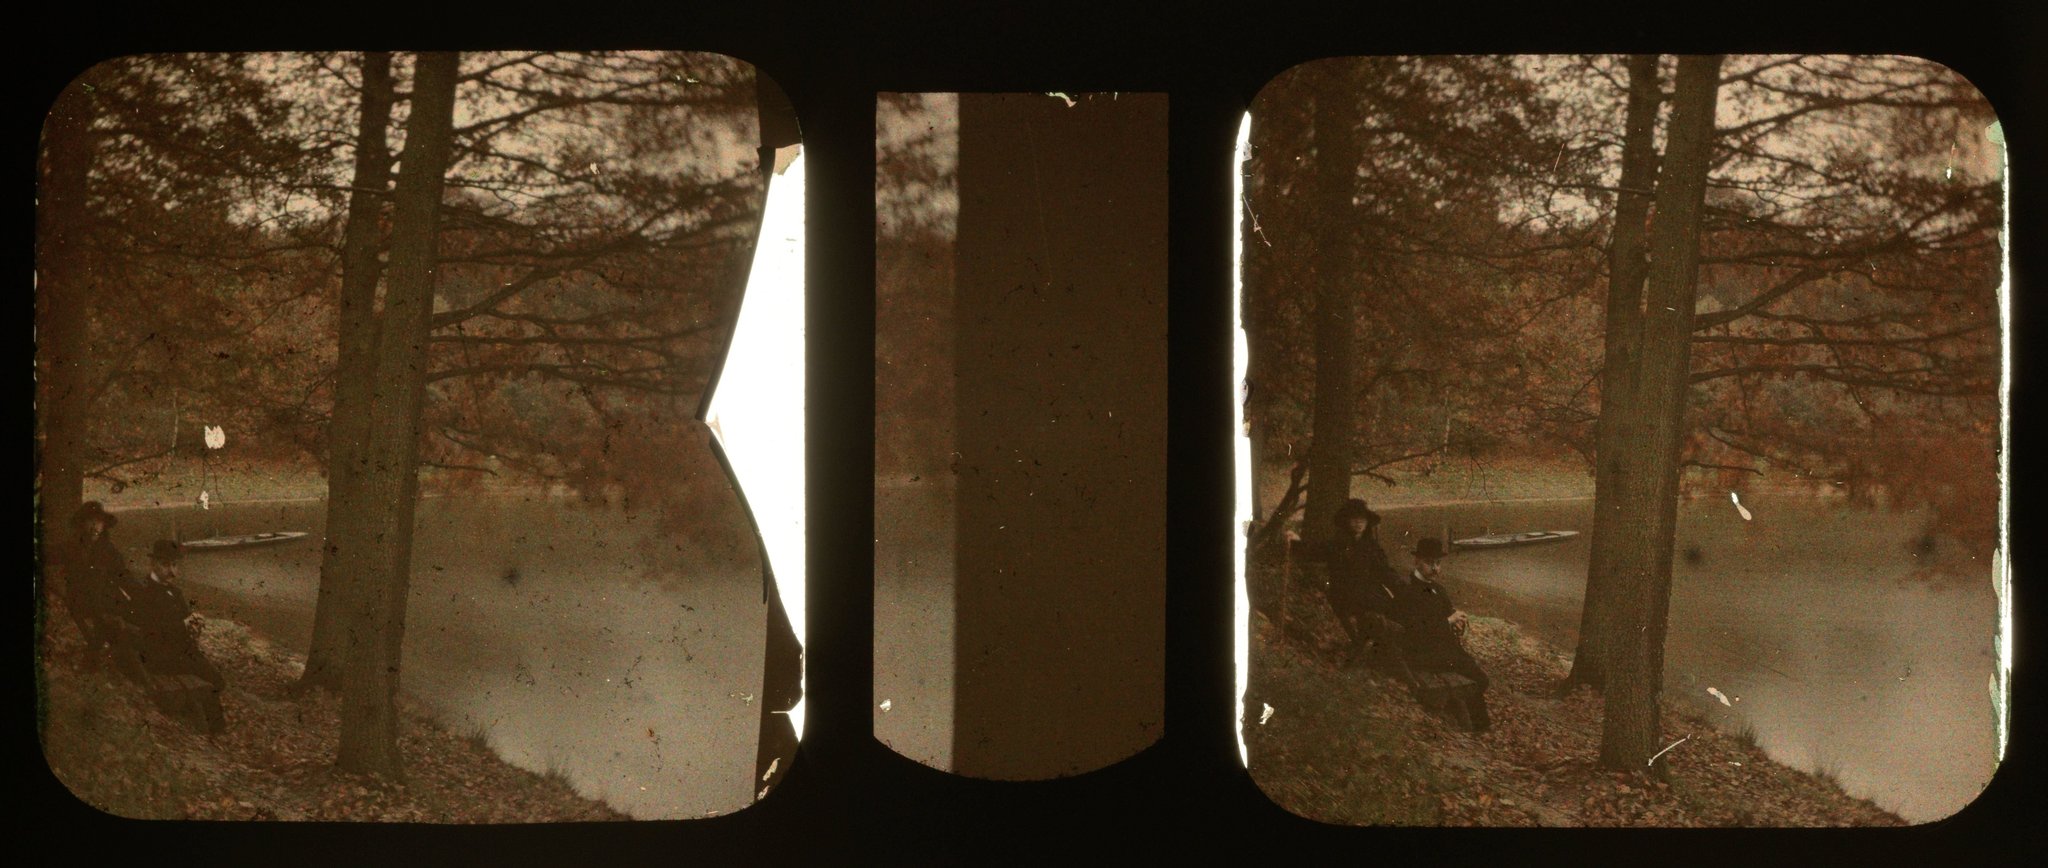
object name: stereoscopic photograph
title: Man en vrouw, zittend aan de waterkant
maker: adolphe burdet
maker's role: fotograaf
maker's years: 1860-1940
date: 1907-1935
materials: glass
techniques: autochrome process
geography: switzerland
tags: trees, adult woman, adult man, lake, switzerland